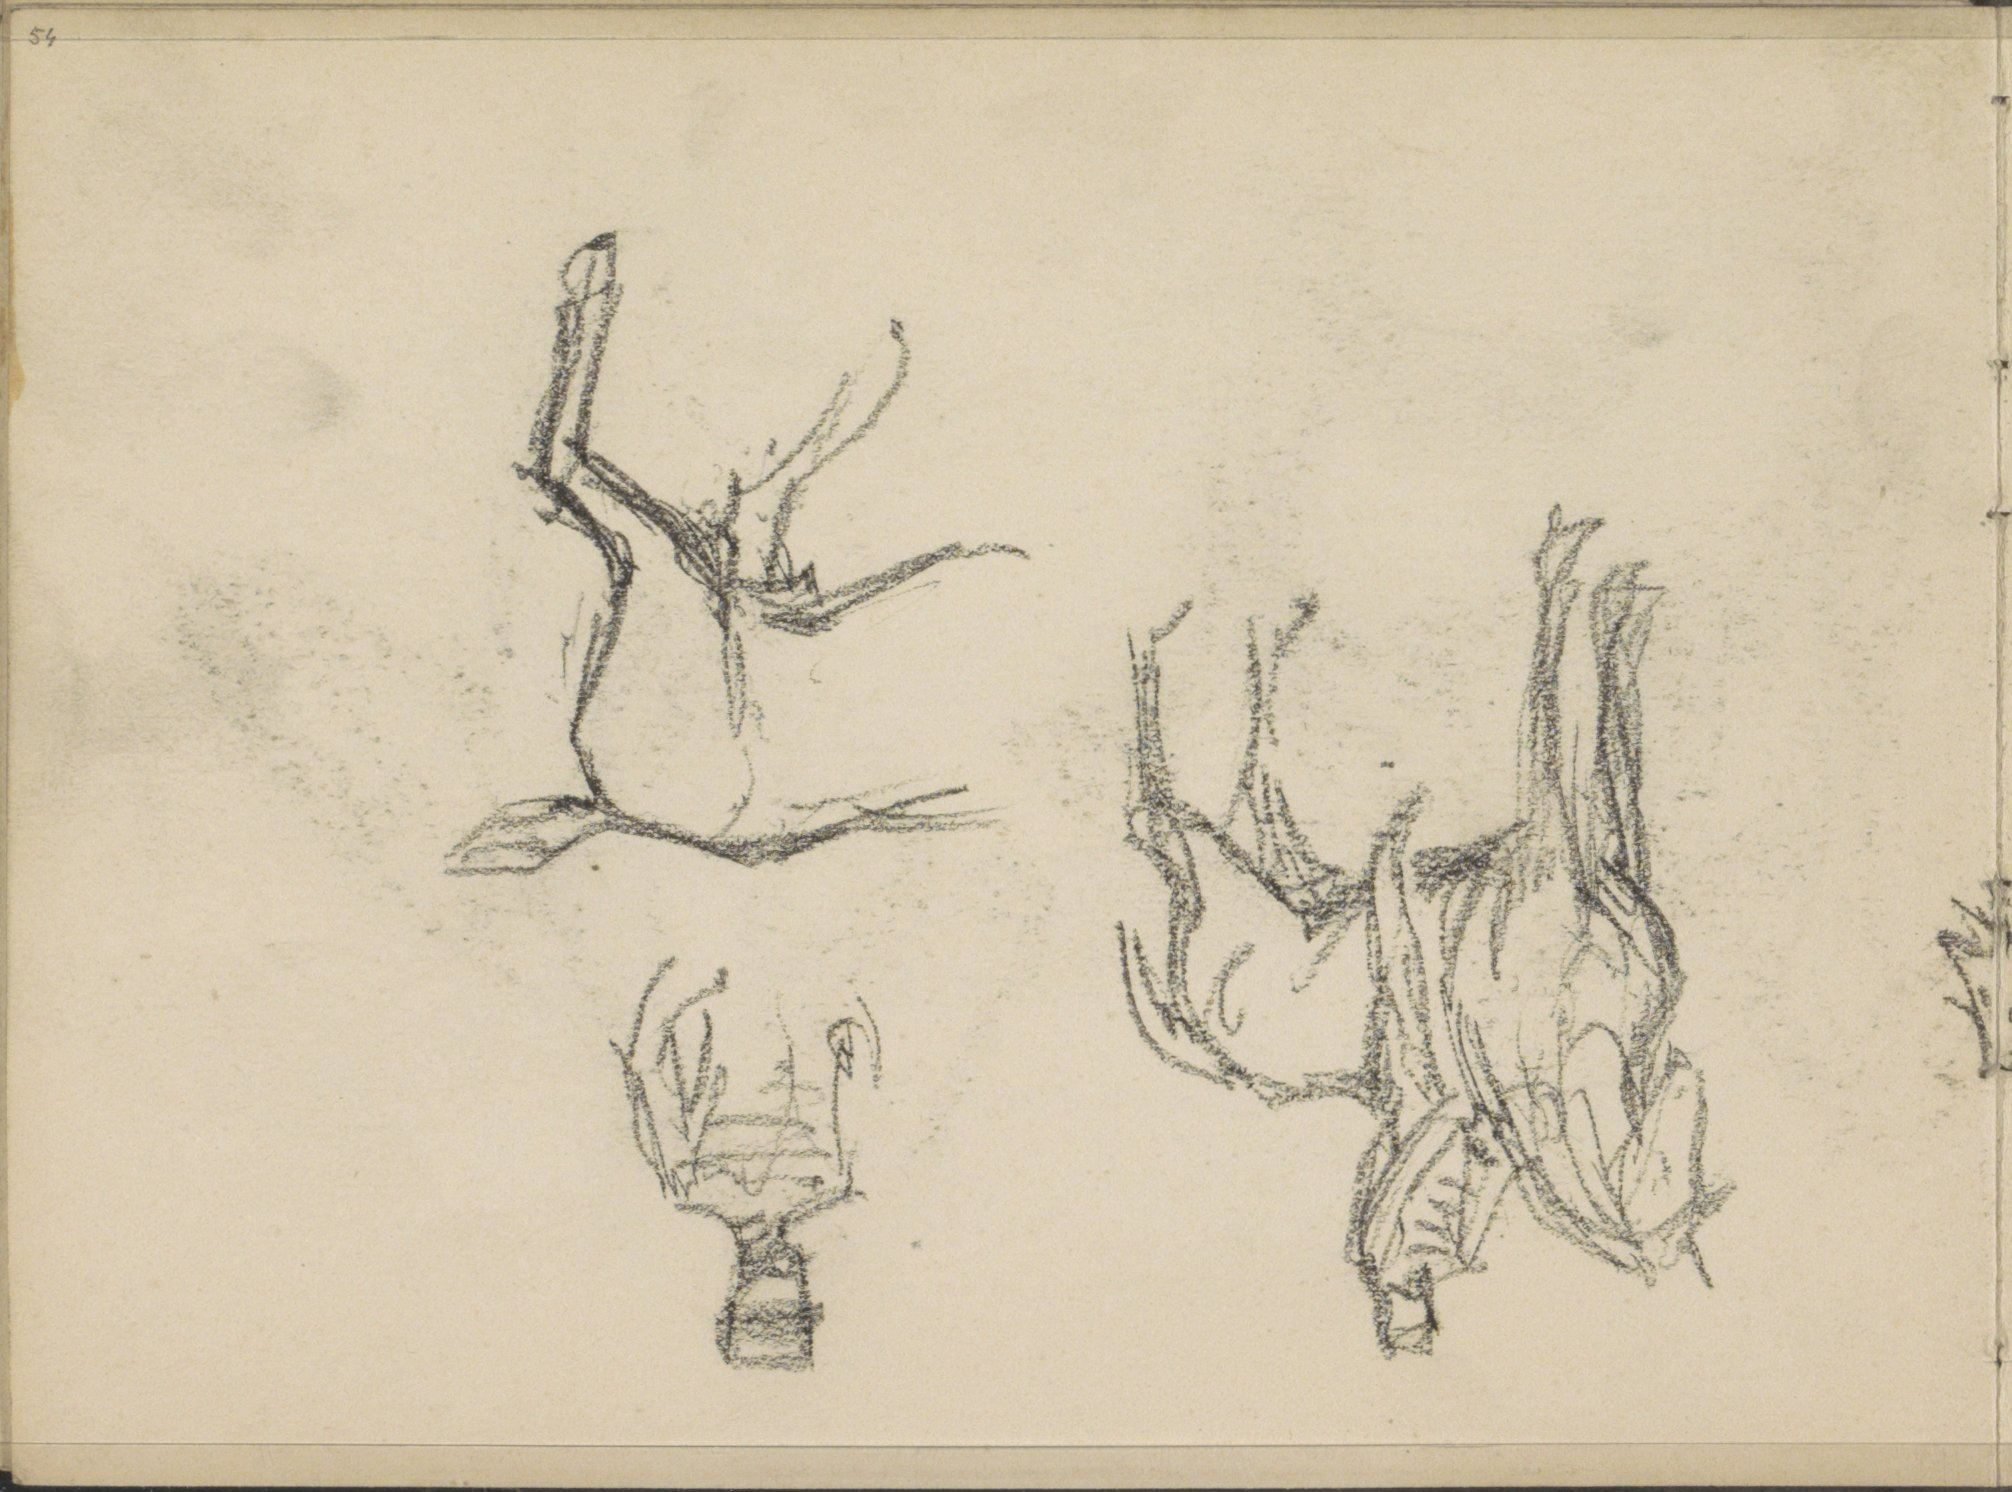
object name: sketchbook leaf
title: Ruiters en paarden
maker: marius bauer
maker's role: draughtsman, print maker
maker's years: 1867-1932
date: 1879-1884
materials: chalk, paper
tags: riding a horse, ass, or mule; rider, horseman, horse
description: De ruiters en paarden zijn vanuit verschillende aanzichten getekend. Pagina 54 en 55 uit een schetsboek met 28 bladen.